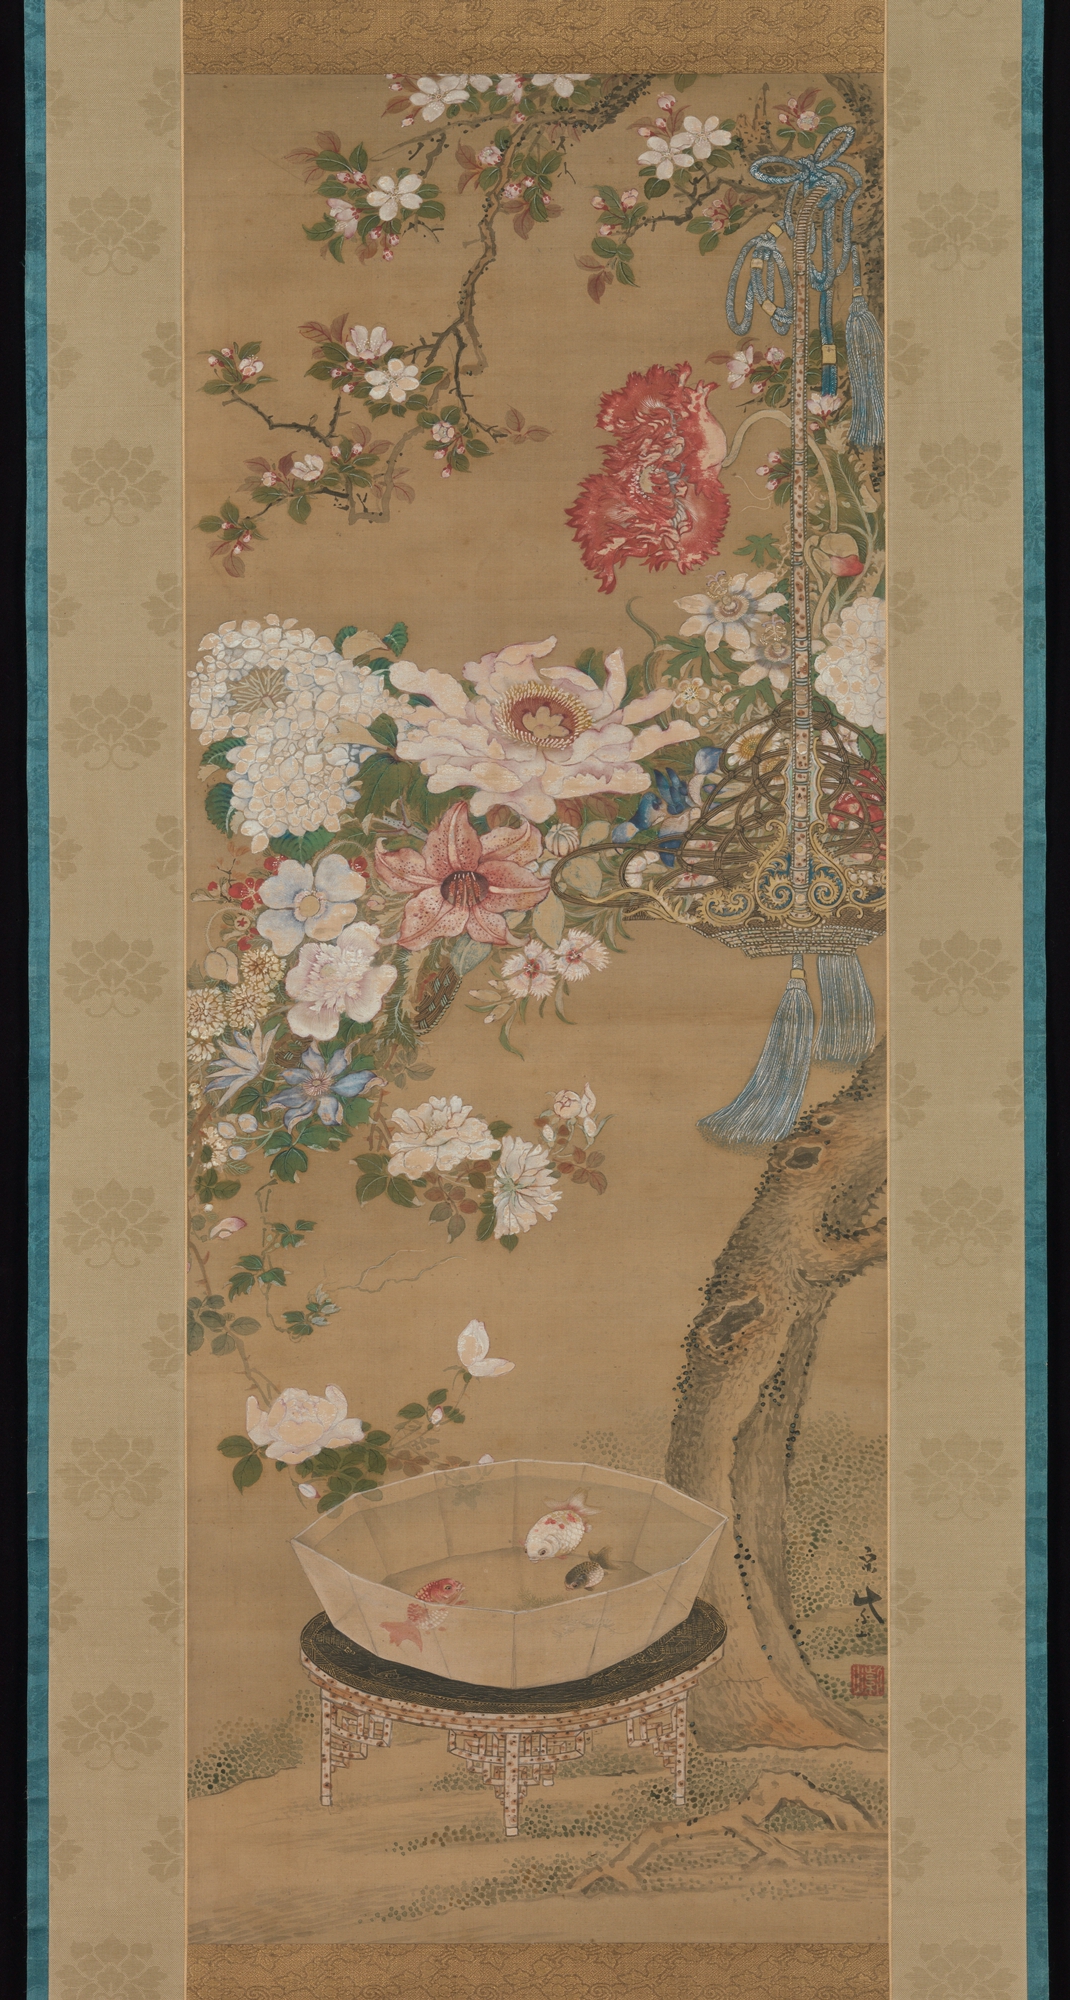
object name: hanging scroll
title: Flowers and Goldfish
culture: japanese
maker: sō shizan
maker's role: artist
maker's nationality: japanese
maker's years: 1733-1805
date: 1701-1800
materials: ink, silk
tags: fish,flowers